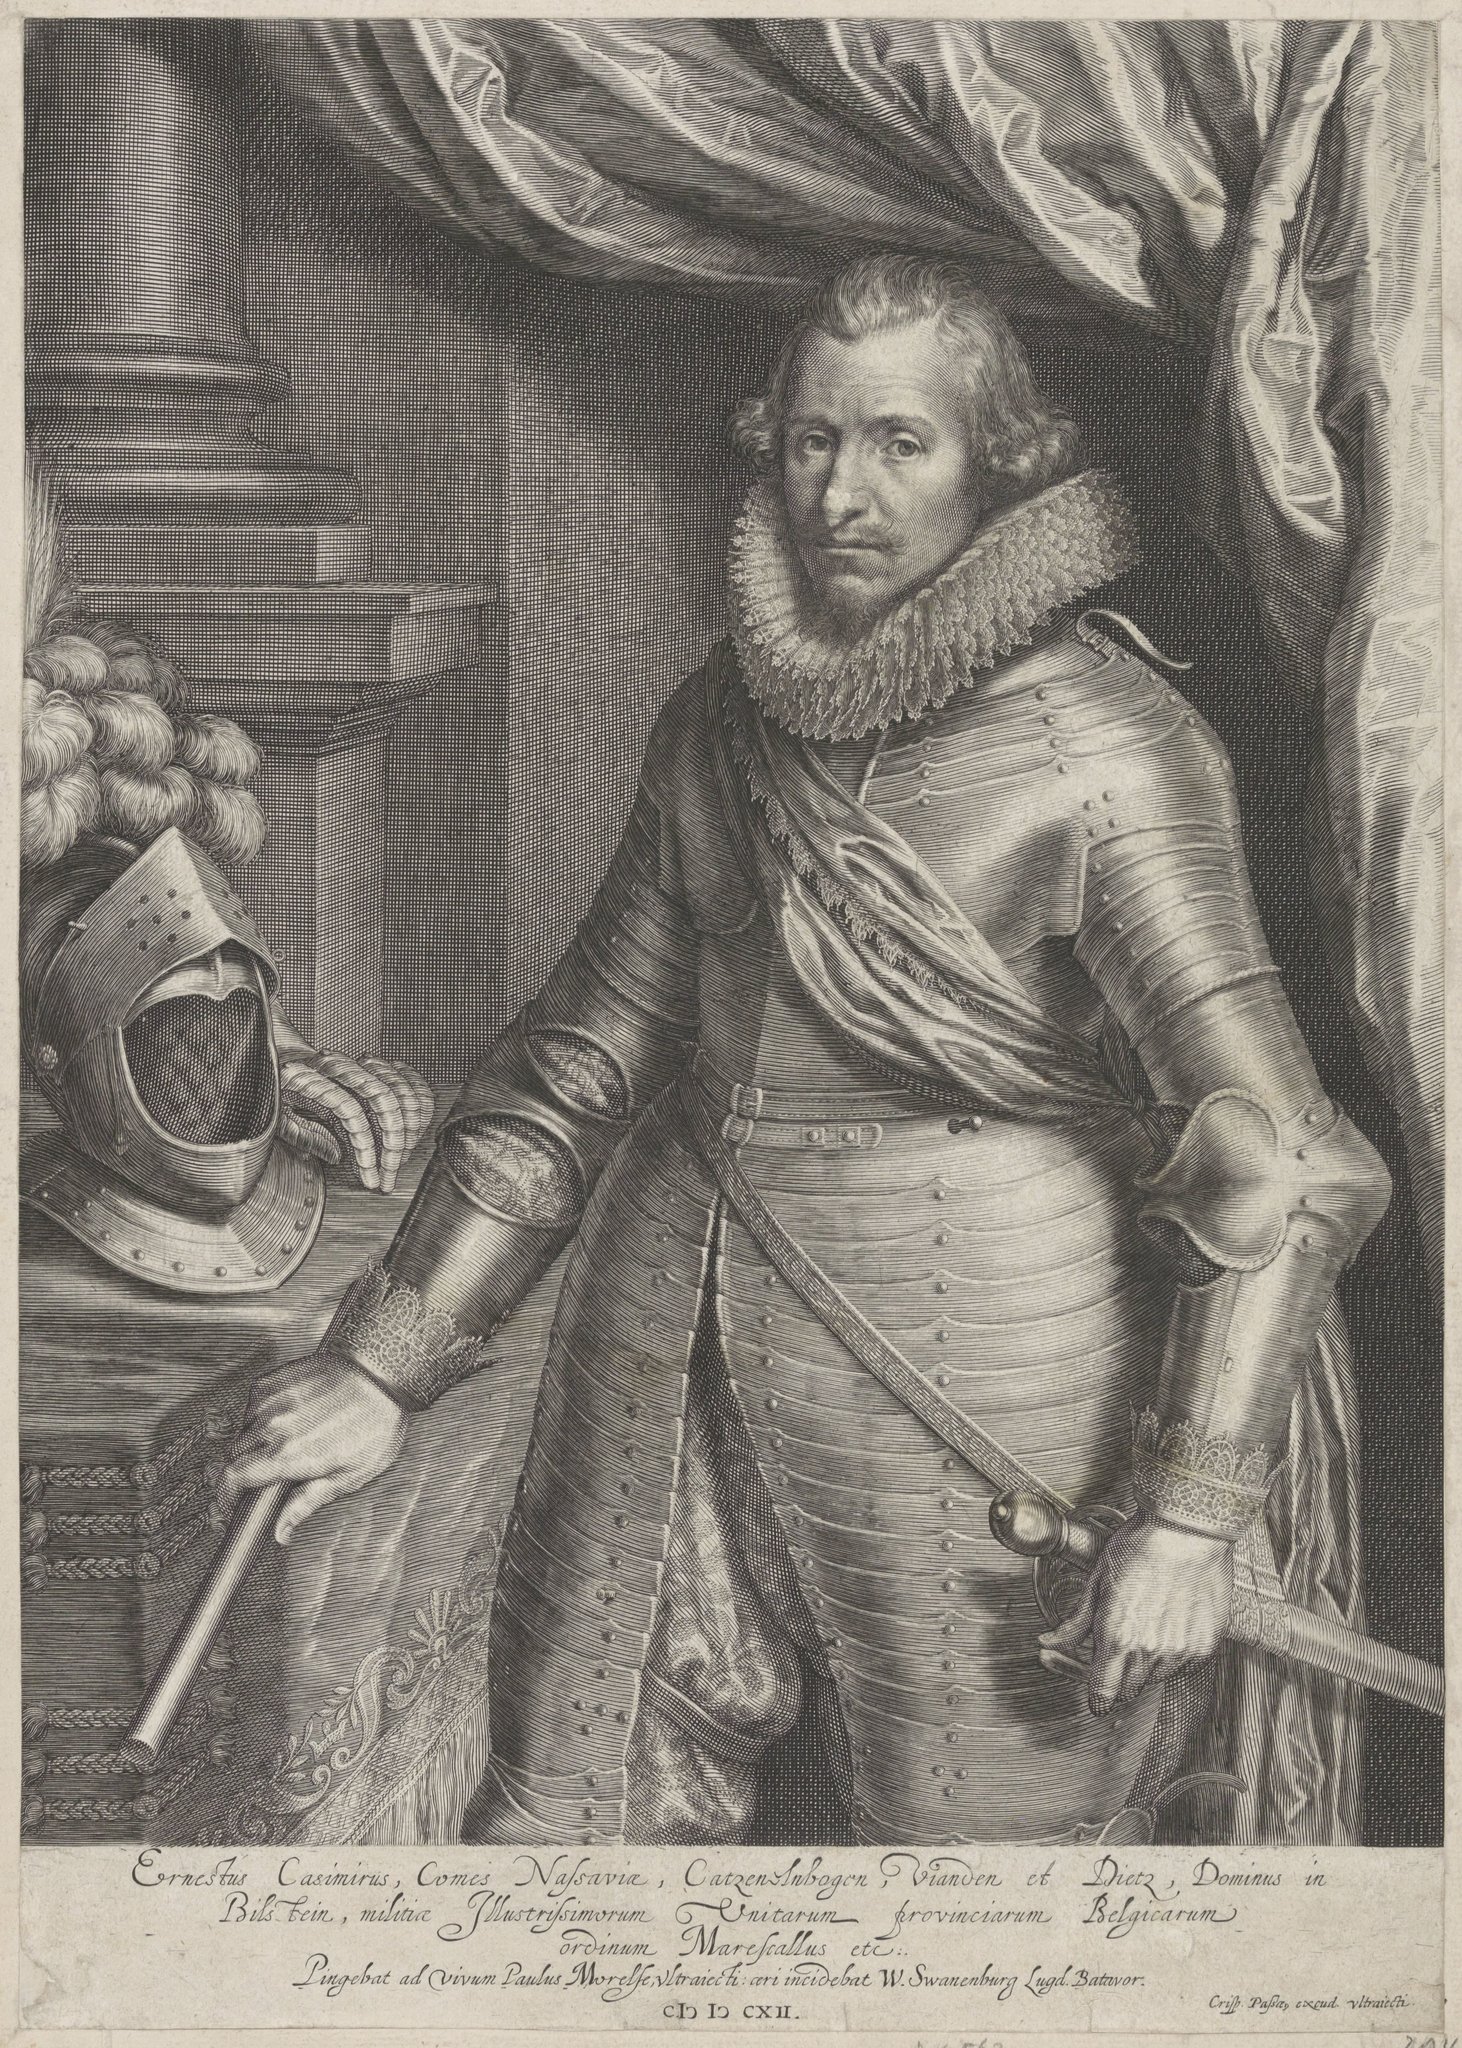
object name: print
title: Portret van Ernst Casimir, graaf van Nassau-Dietz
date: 1612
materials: paper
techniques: engraving, etching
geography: utrecht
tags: ernst casimir graaf van nassau-dietz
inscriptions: date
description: De hier vermelde titel verwijst naar de hoogst verkregen titel van de geportretteerde, niet per se naar de titel die de geportretteerde op deze voorstelling draagt.